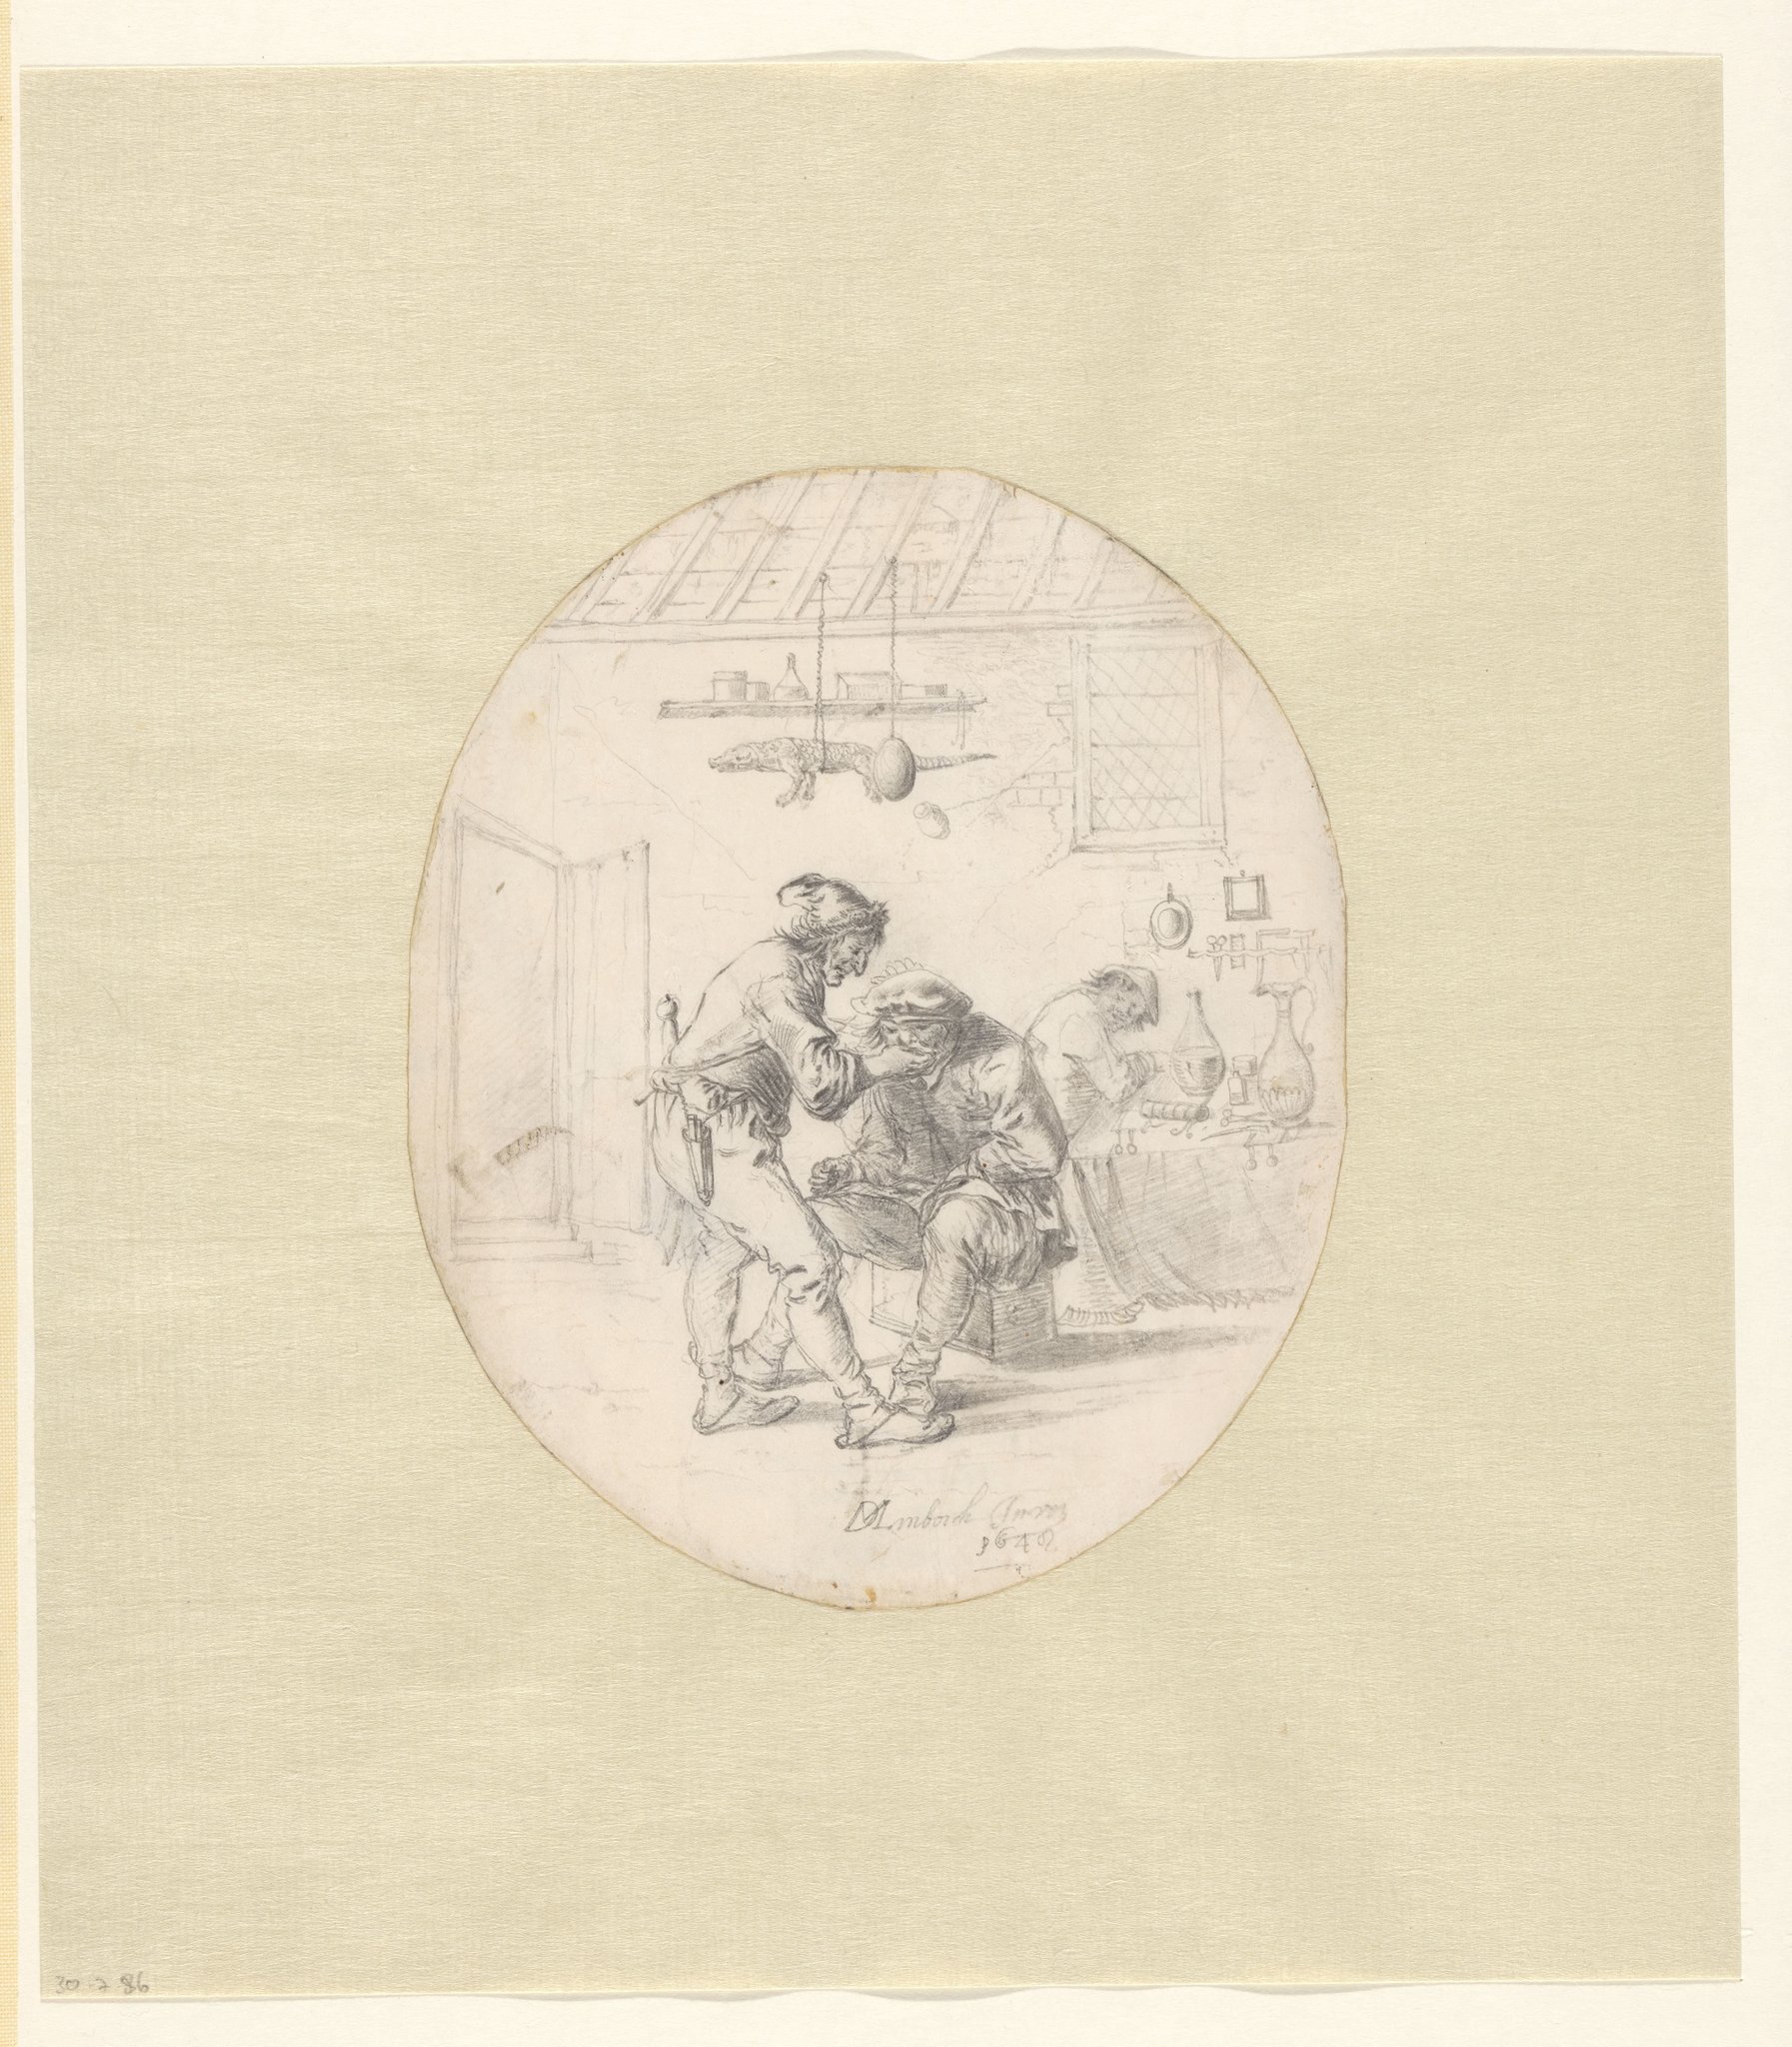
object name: drawing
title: Chirurgijn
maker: michiel d.van limborch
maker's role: draughtsman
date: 1648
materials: parchment, pencil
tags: barber; surgeon, (barber as) dentist, quack extracting teeth or molars